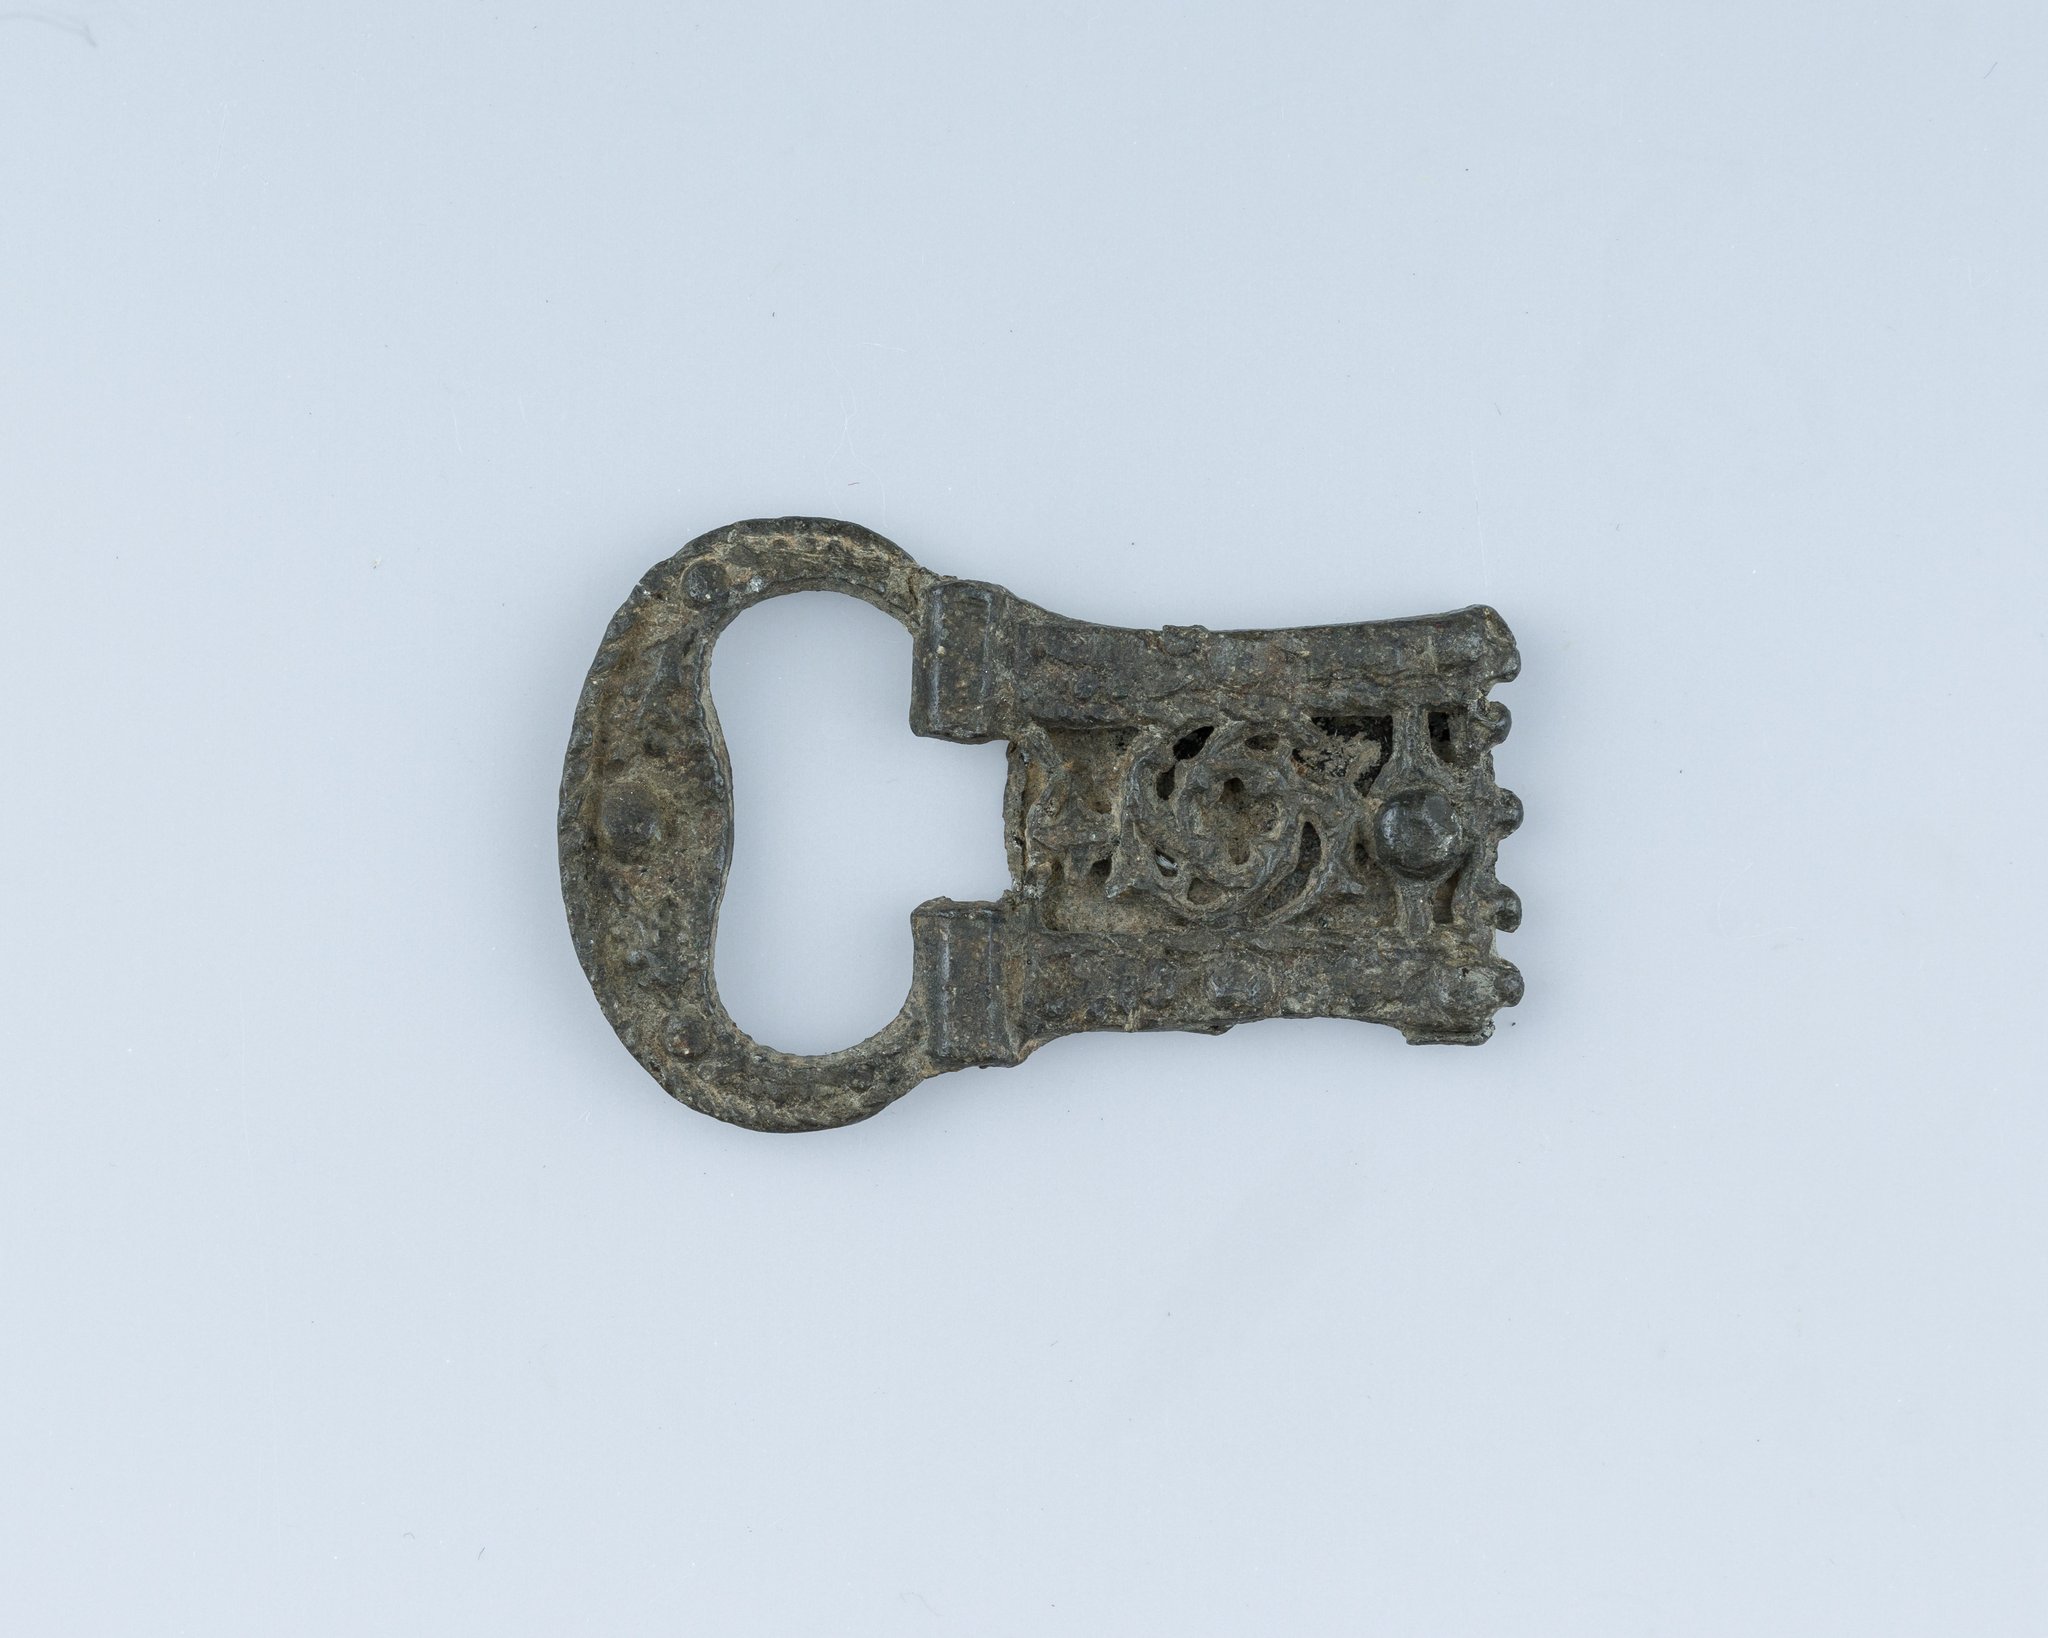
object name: buckle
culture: french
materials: bronze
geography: france